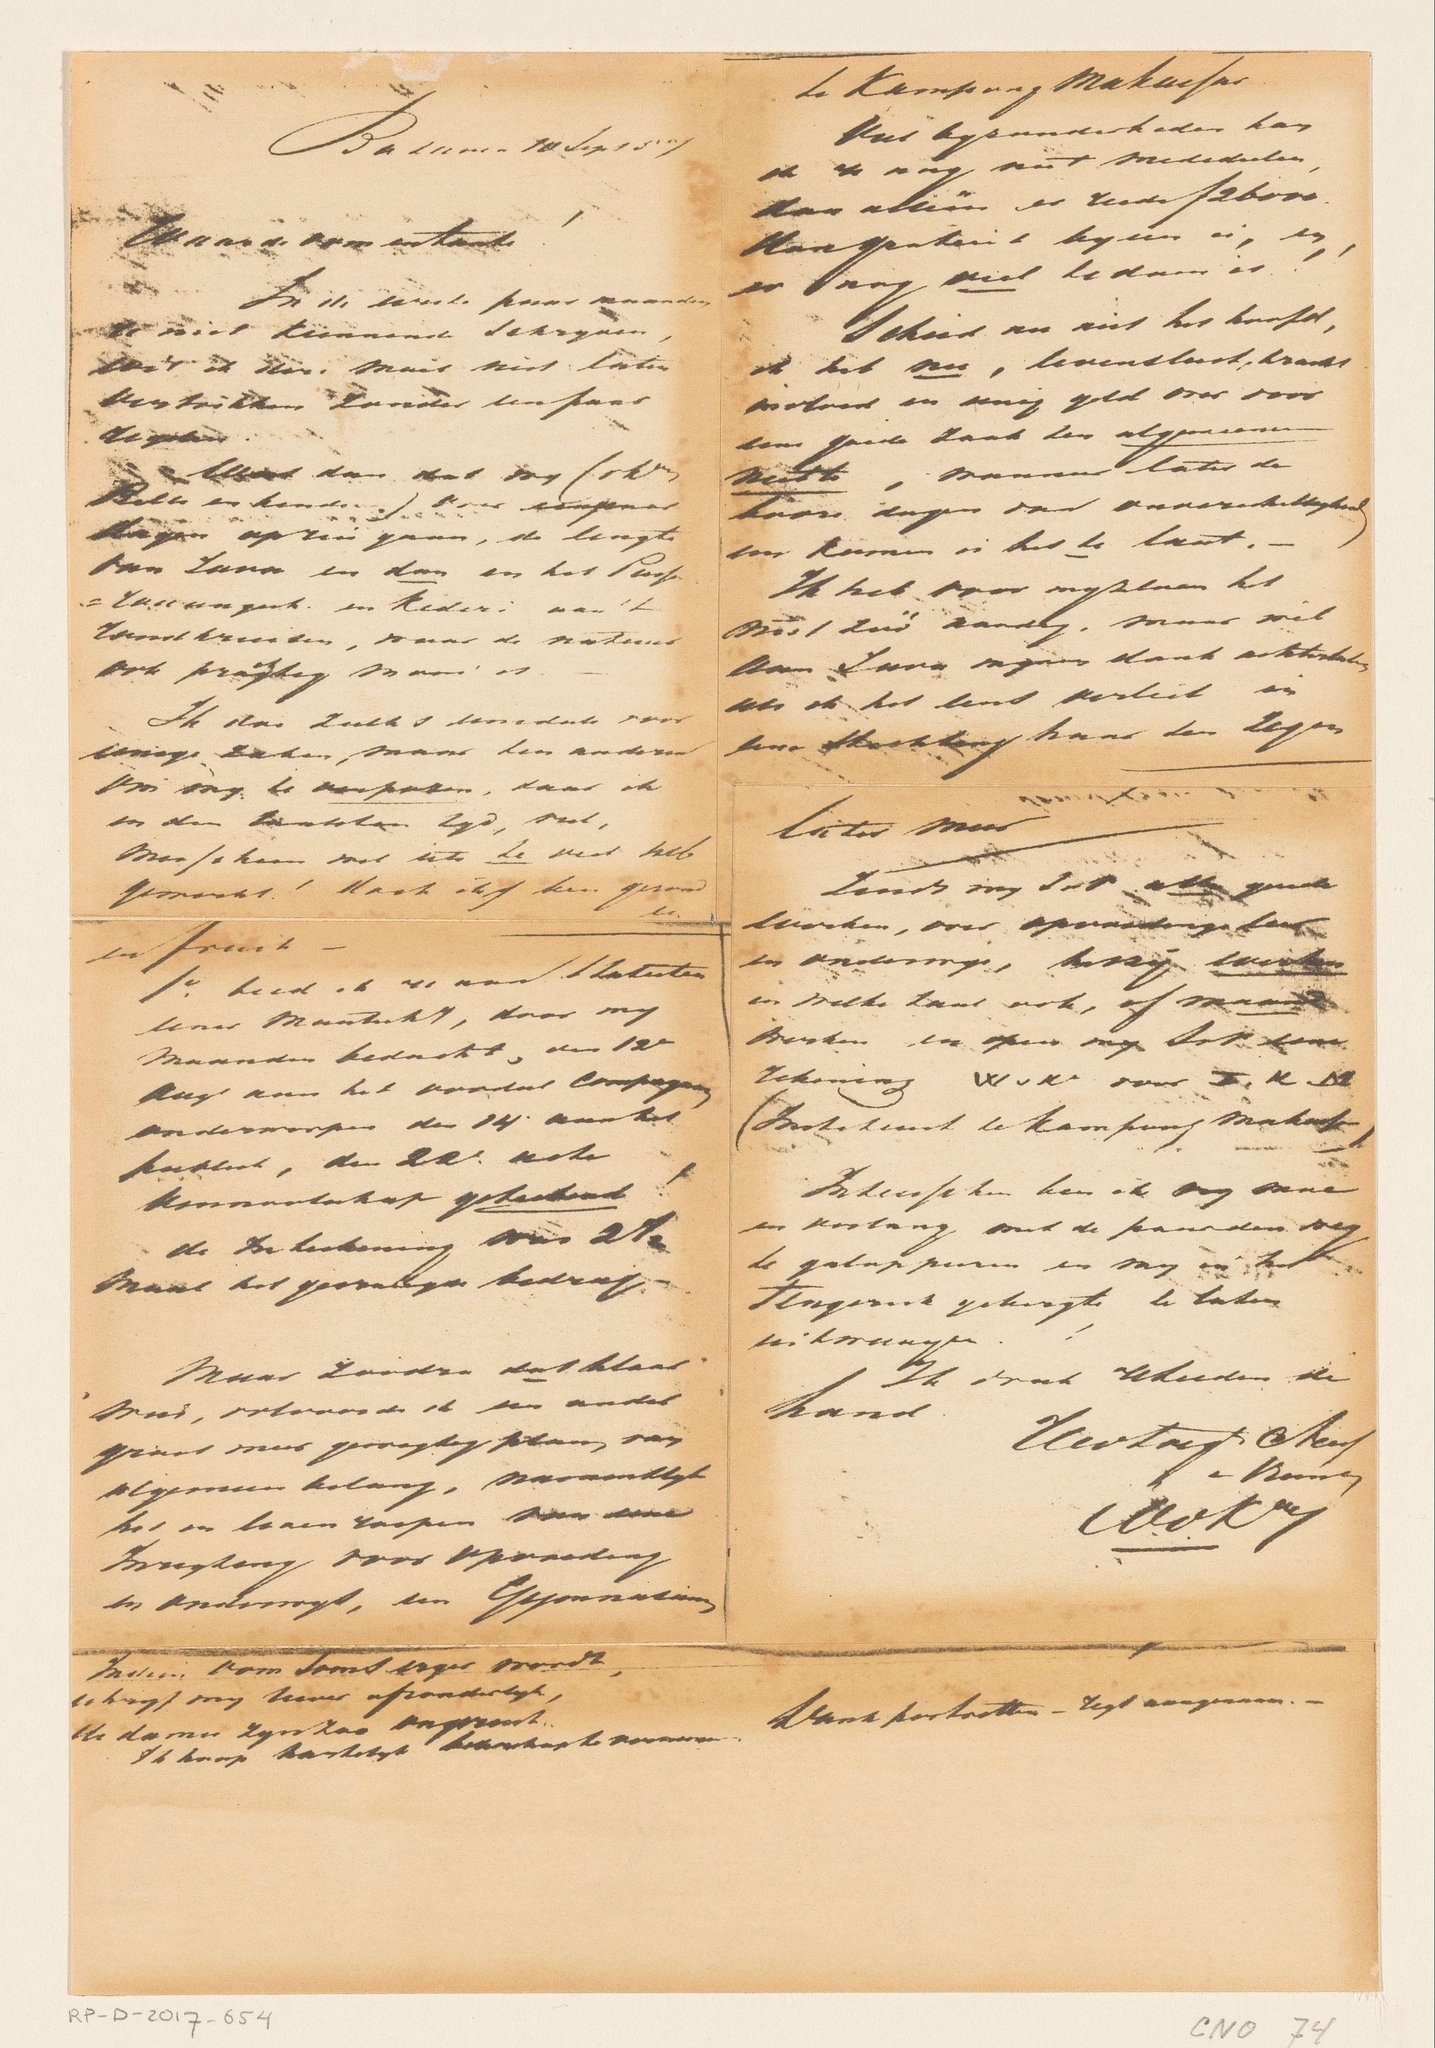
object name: letter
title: Brief van de heer Wichers van Kerchem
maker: de heer wichers van kerchem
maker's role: ondernemer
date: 1857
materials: ink, paper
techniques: pen, writing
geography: batavia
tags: de heer wichers van kerchem, education, trade, commerce and finance, batavia